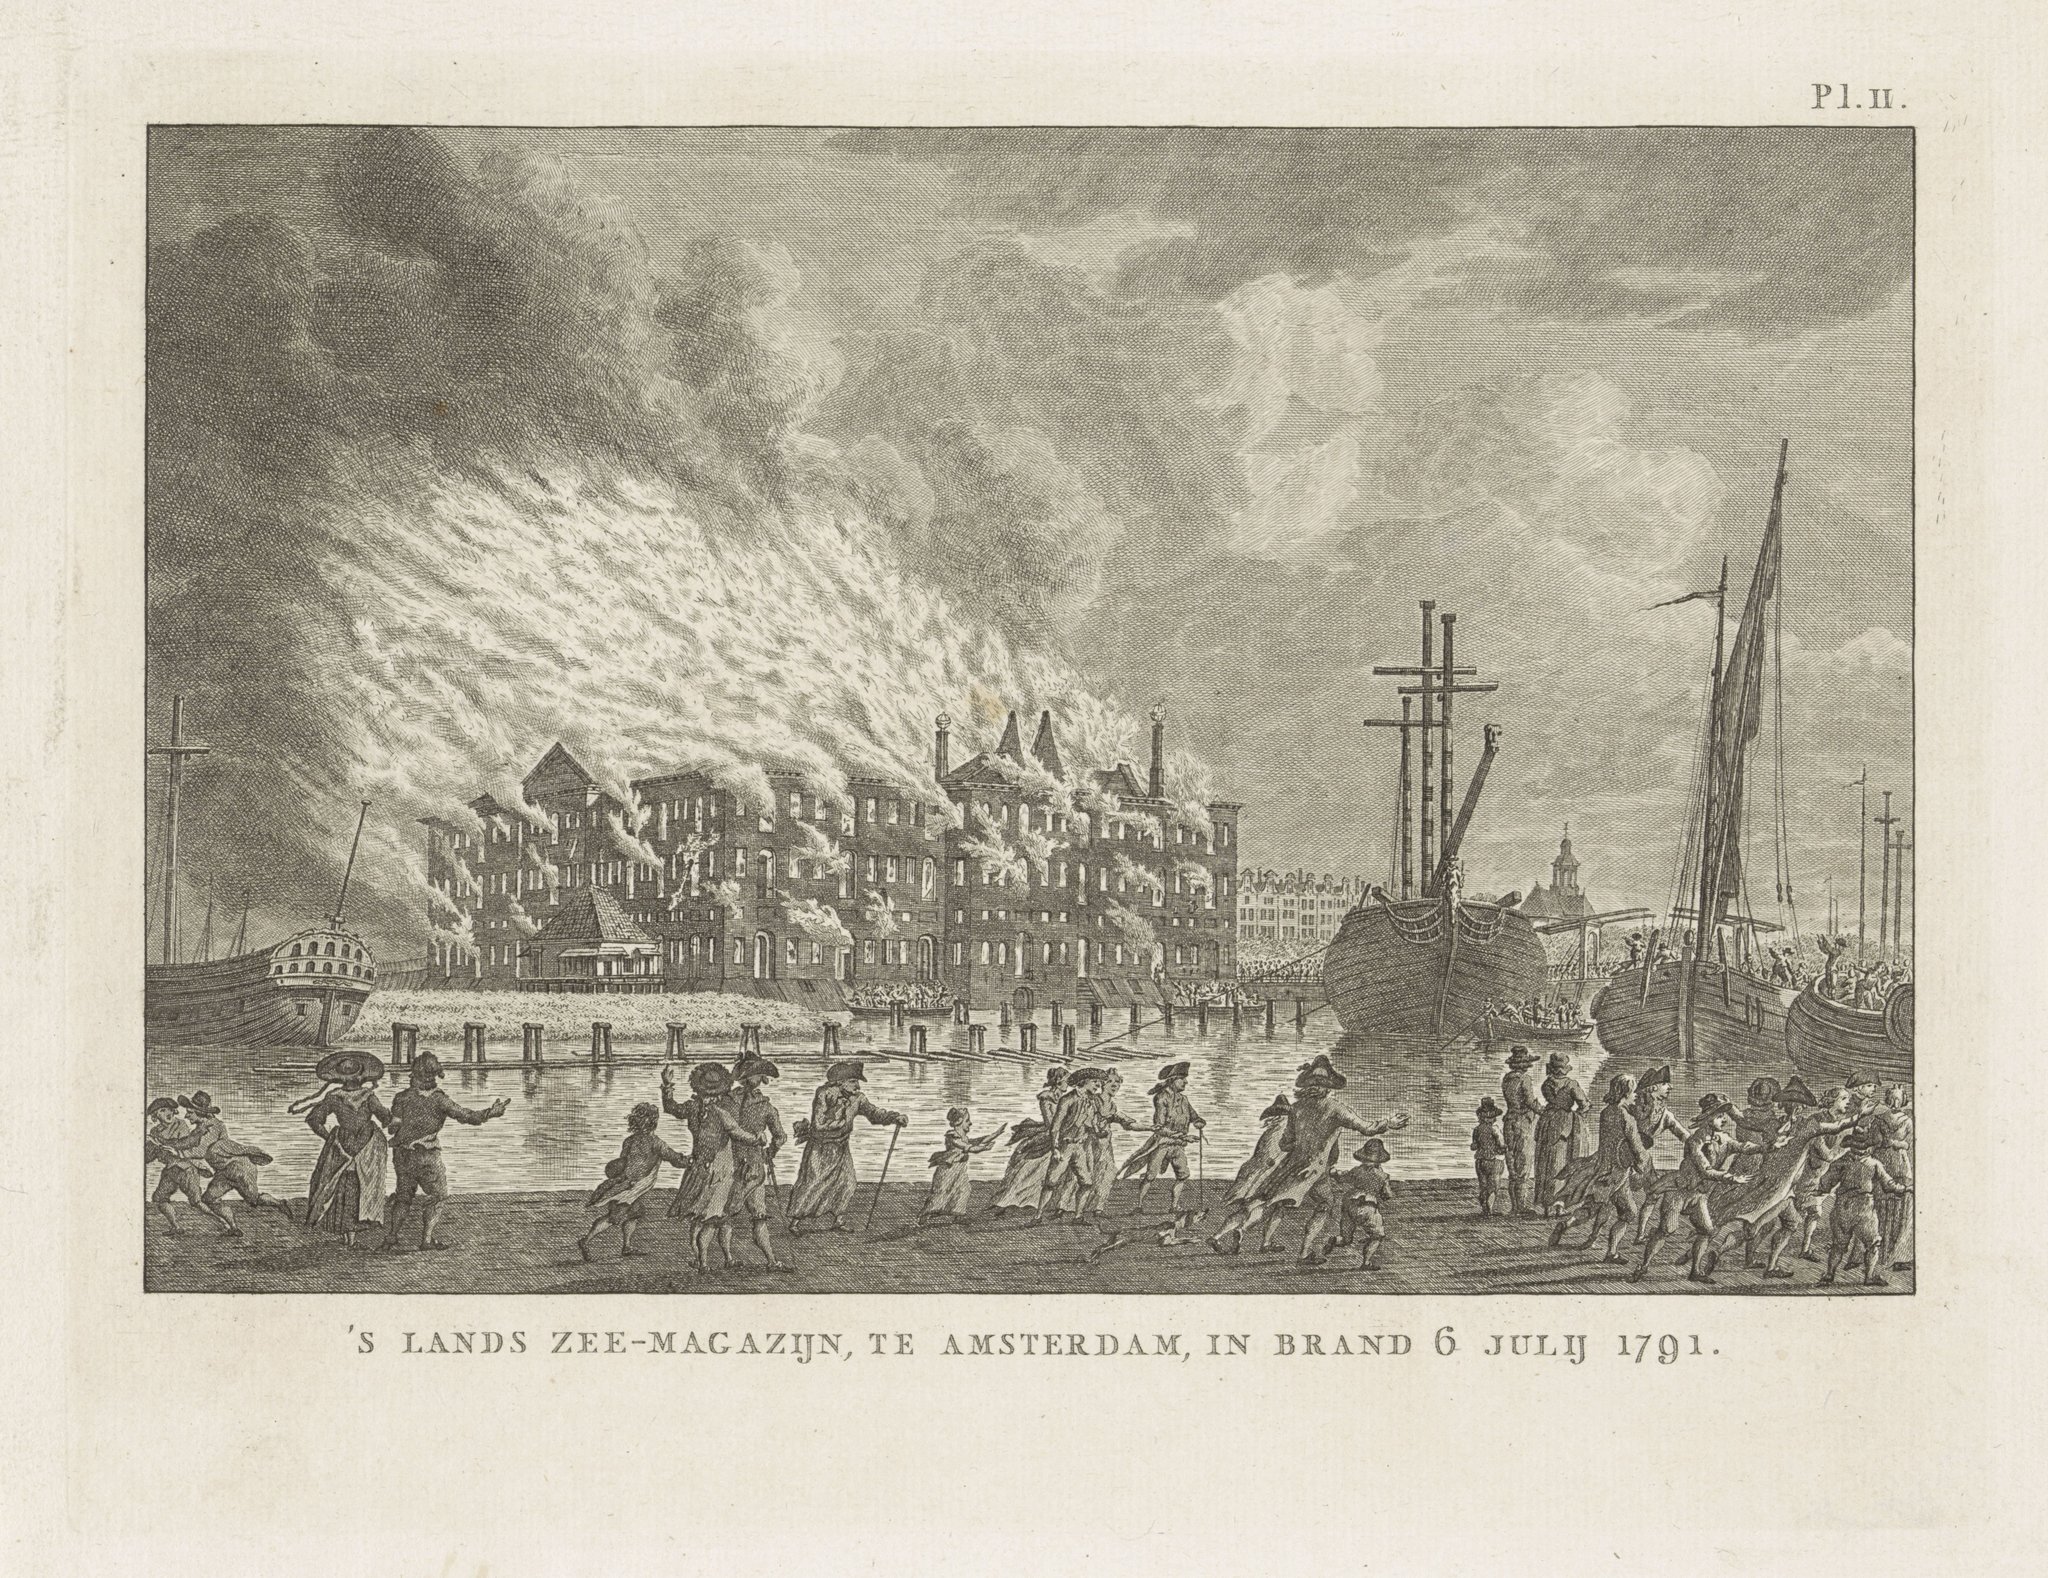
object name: print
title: 's Lands Zee-magazijn, te Amsterdam, in brand 6 July 1791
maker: Anonymous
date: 1791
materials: paper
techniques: engraving, etching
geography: northern netherlands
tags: on fire, ablaze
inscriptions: collector's mark: Lugt 2228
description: Gebruikt als illustratie in: 'sLands zee-magazĳn, te Amsterdam, beschouwd vóór, bĳ en na den geweldigen brand van (...) julĳ deezes jaars. Amsterdam: J.W. Smit, 1791.